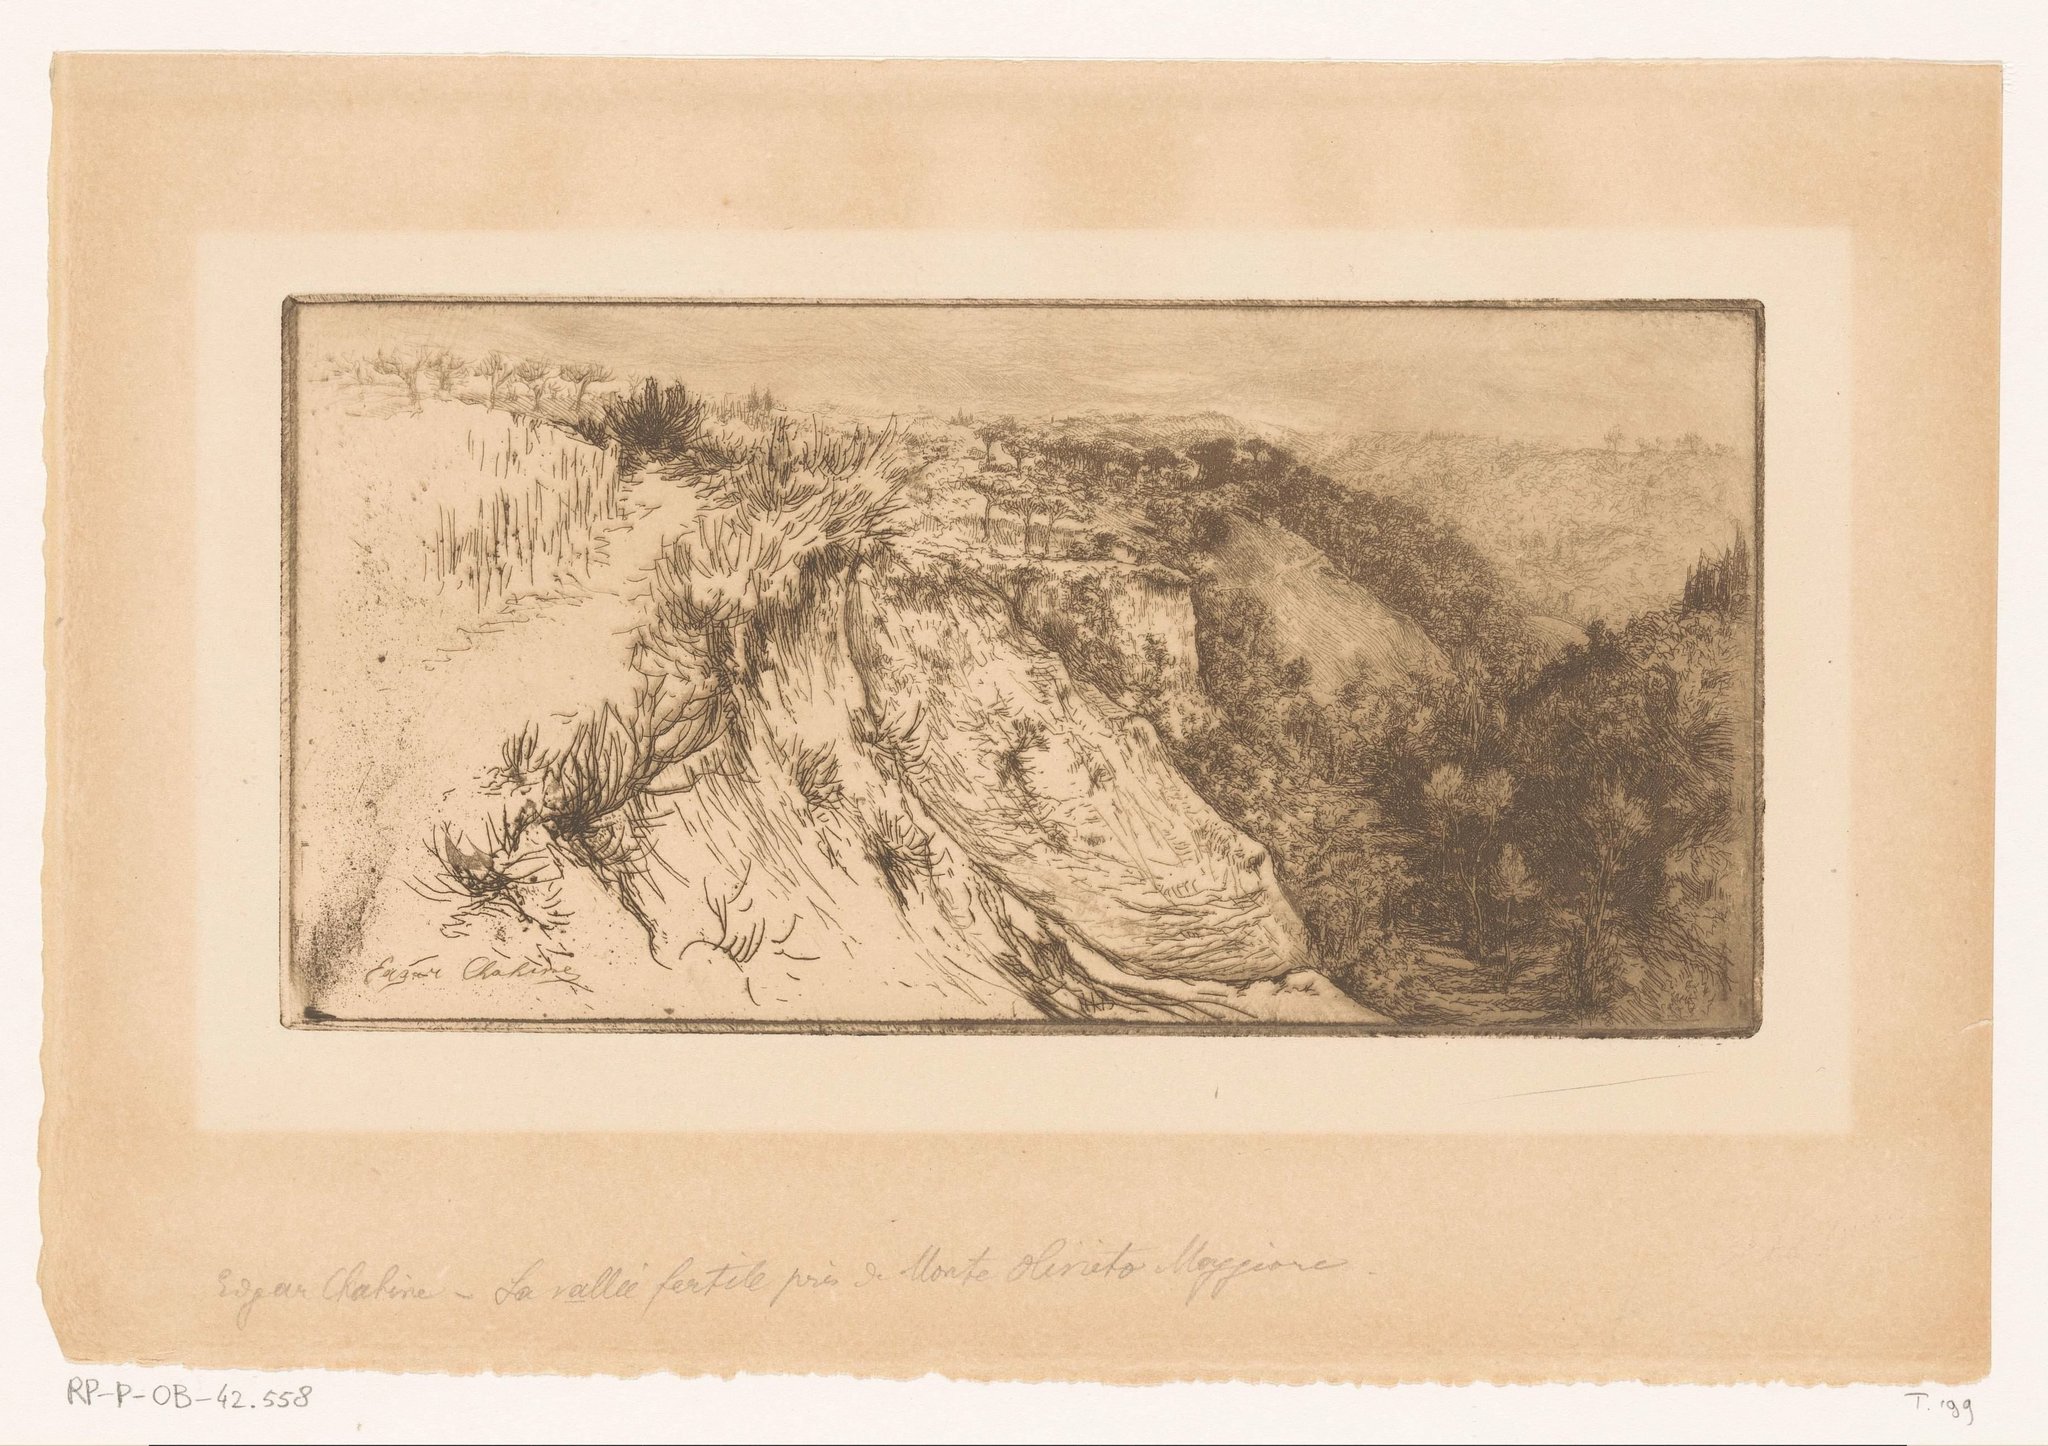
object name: print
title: Vallei bij Monte Oliveto Maggiore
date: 1906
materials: paper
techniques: drypoint, etching, intaglio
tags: dale, valley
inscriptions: collector's mark: Lugt 2228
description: Maakt deel uit van een serie getiteld: "Impressions d'Italie", bestaande uit vijftig platen en een titelprent met verschillende gezichten op Italië.